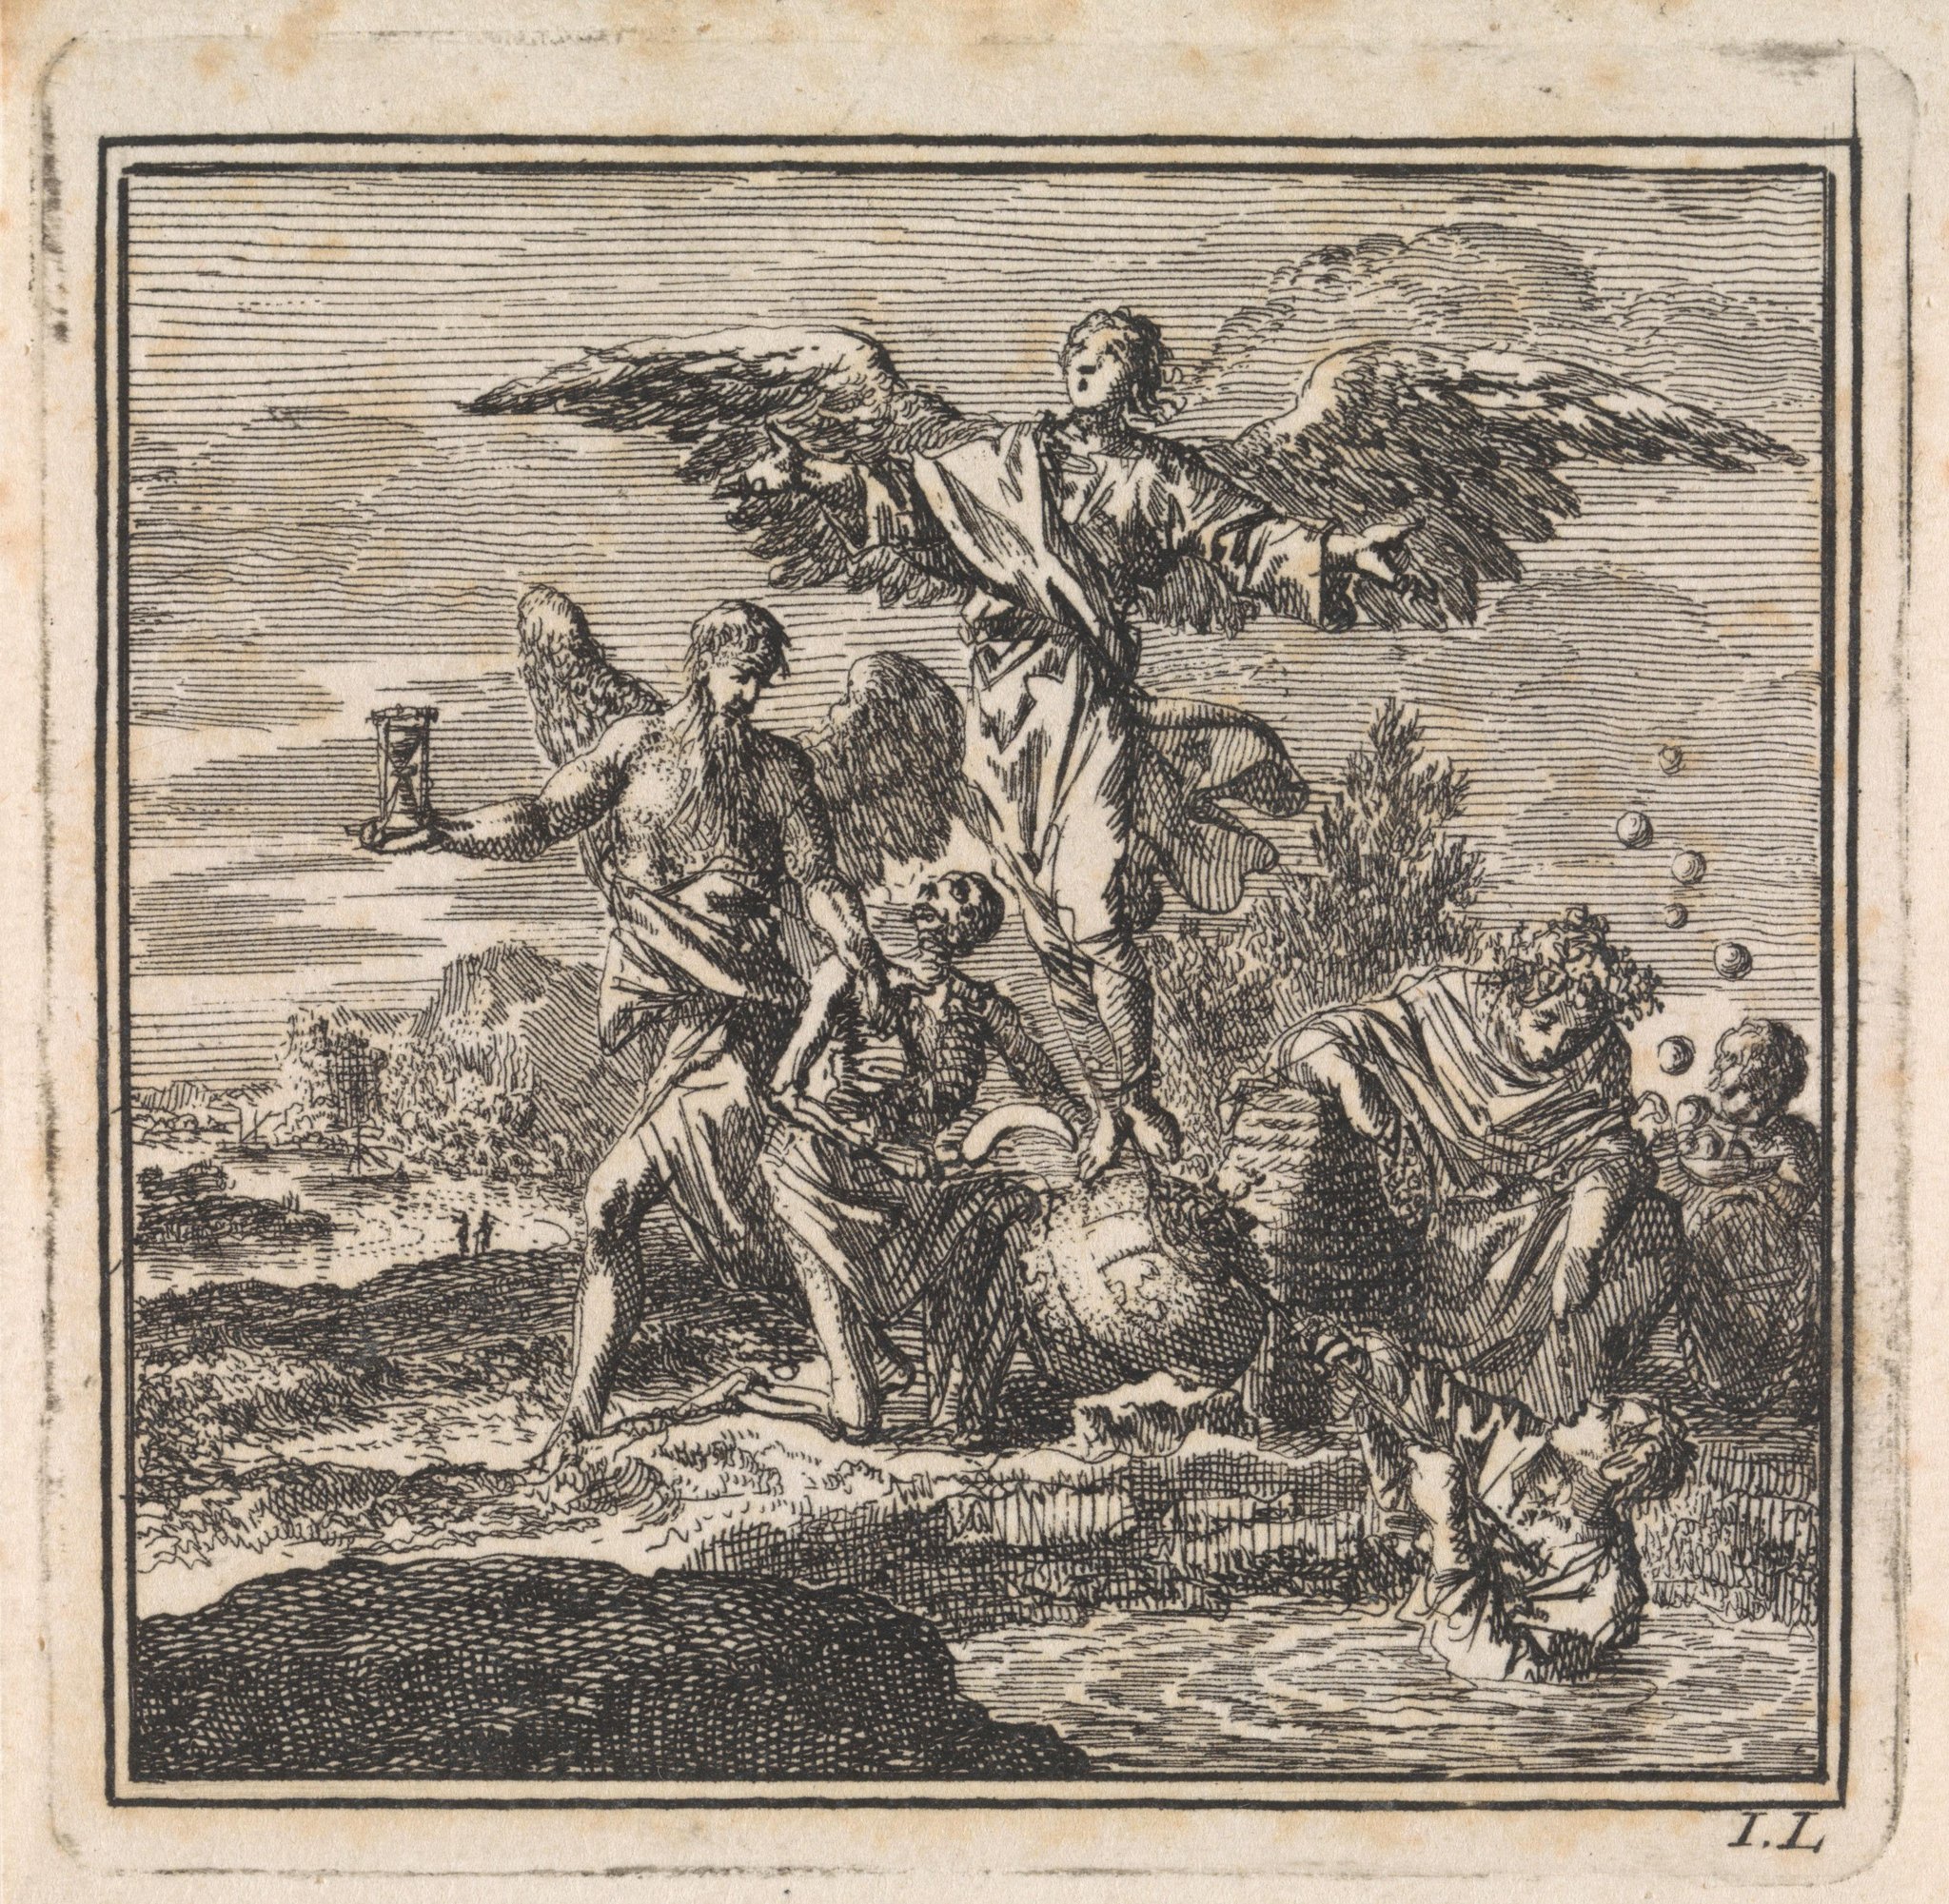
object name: print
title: Het gewigtige Onderscheid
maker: jan luyken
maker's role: draughtsman, print maker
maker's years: 1649-1712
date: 1710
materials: paper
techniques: etching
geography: amsterdam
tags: fabulous beings with wings - aa - female human figure, globe, father time, man with wings and scythe, death as skeleton - ff - death as female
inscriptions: collector's mark: Lugt 2228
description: Illustratie uit: Luyken, Jan. De onwaardige wereld, vertoond in vyftig zinnebeelden, met godlyke spreuken en stichtelyke verzen. Amsterdam: Pieter Arentsz. II (wed.) en Cornelis van der Sys, 1710, p. 6.